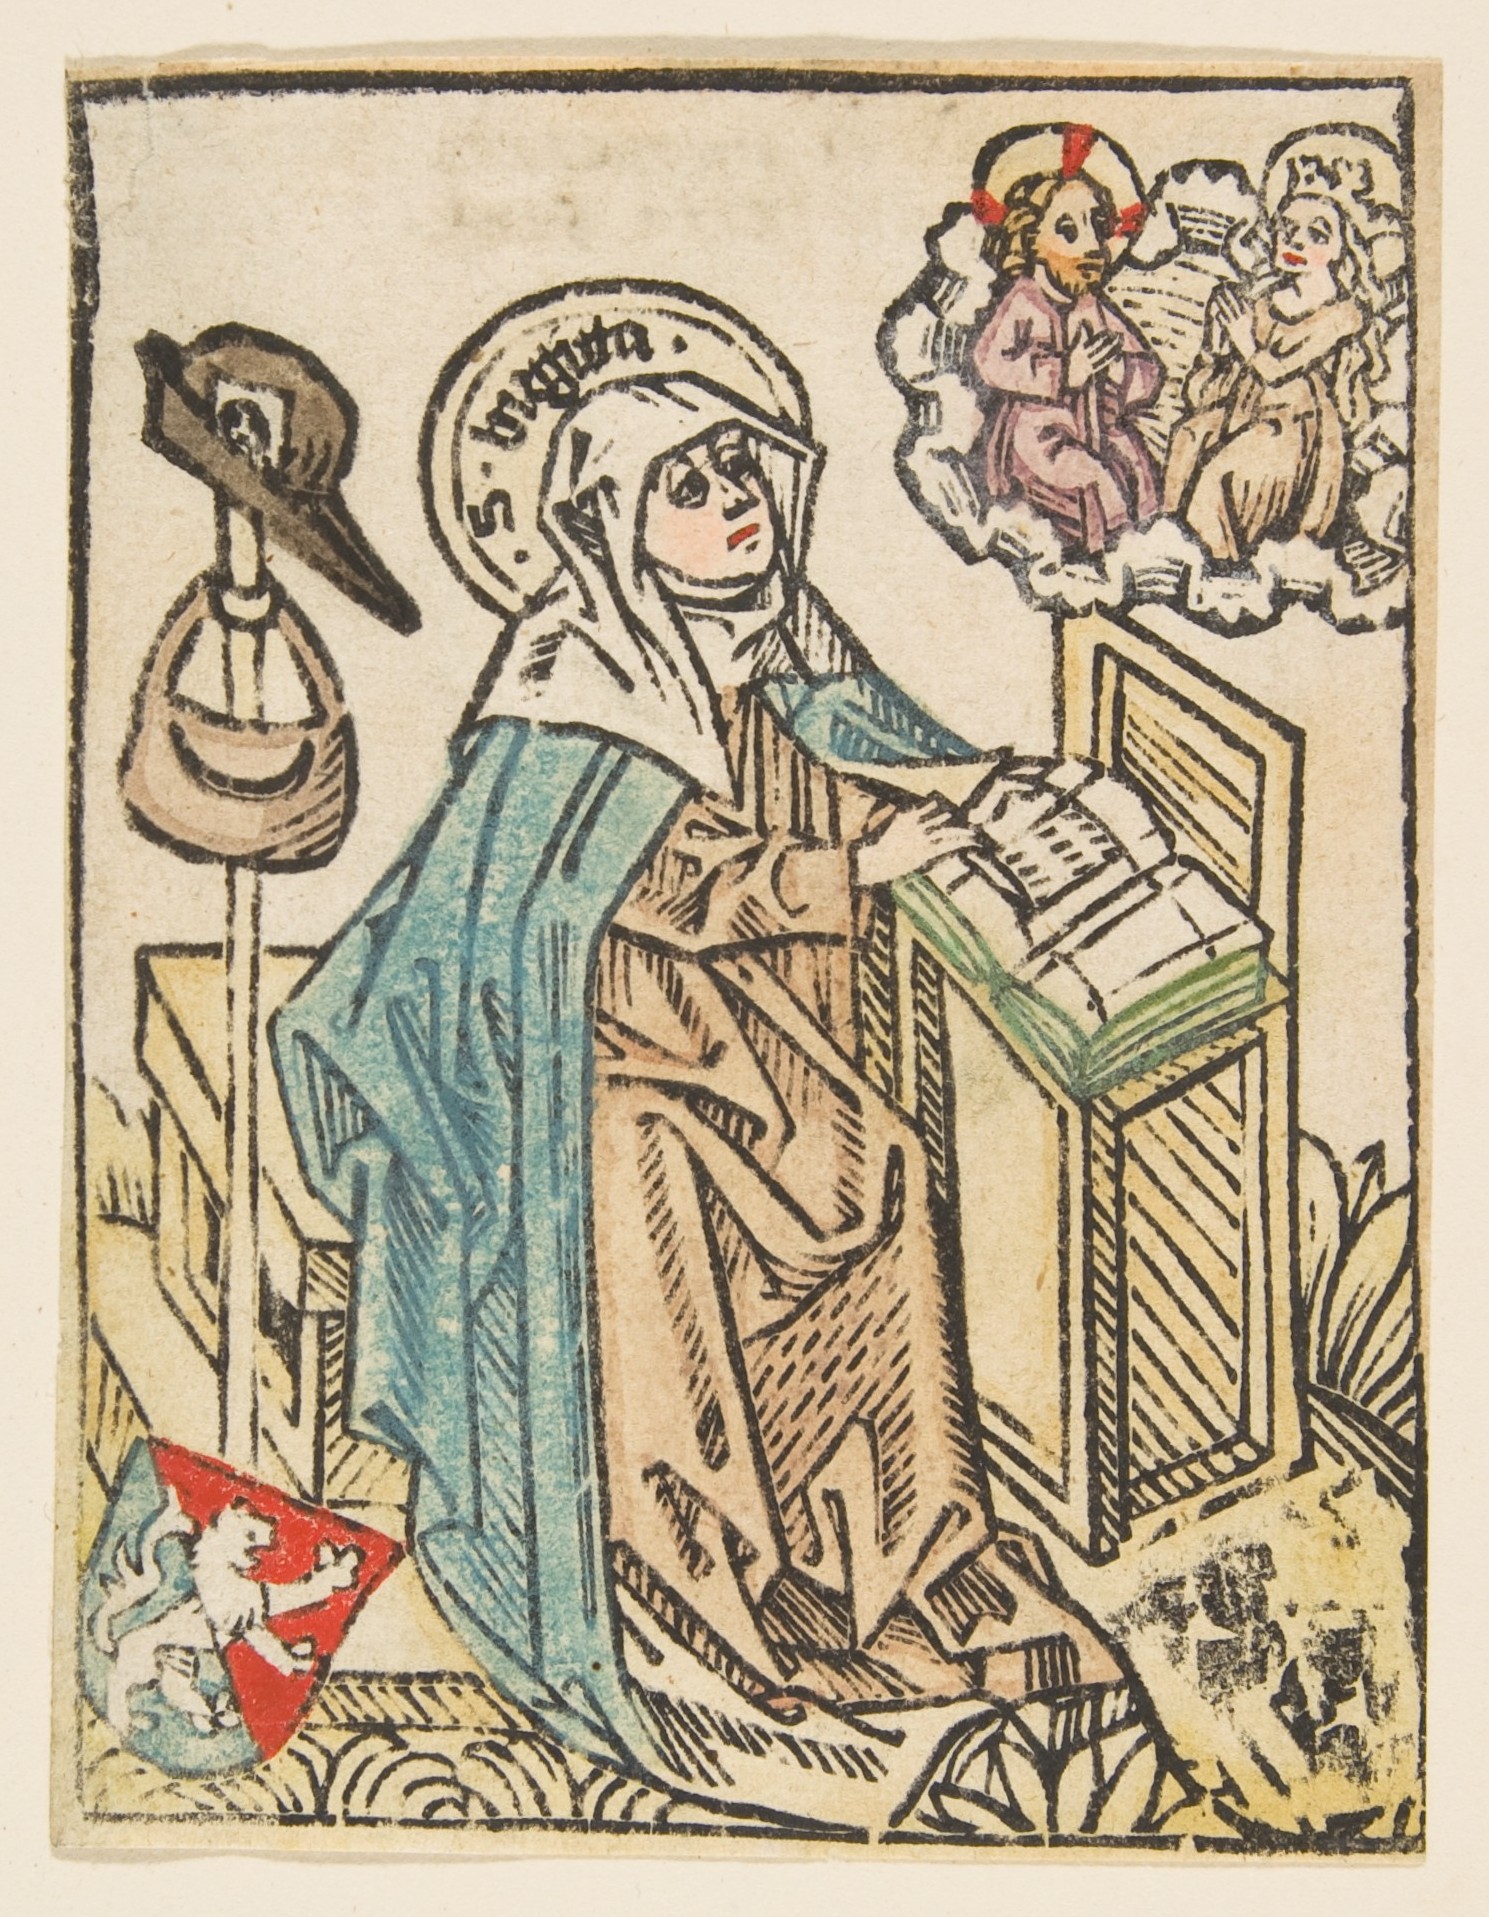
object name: print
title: St. Bridget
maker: anonymous, german, 15th century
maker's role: artist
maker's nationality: german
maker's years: 1400-1500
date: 1401-1500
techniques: hand coloring, woodcut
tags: books,women,saints